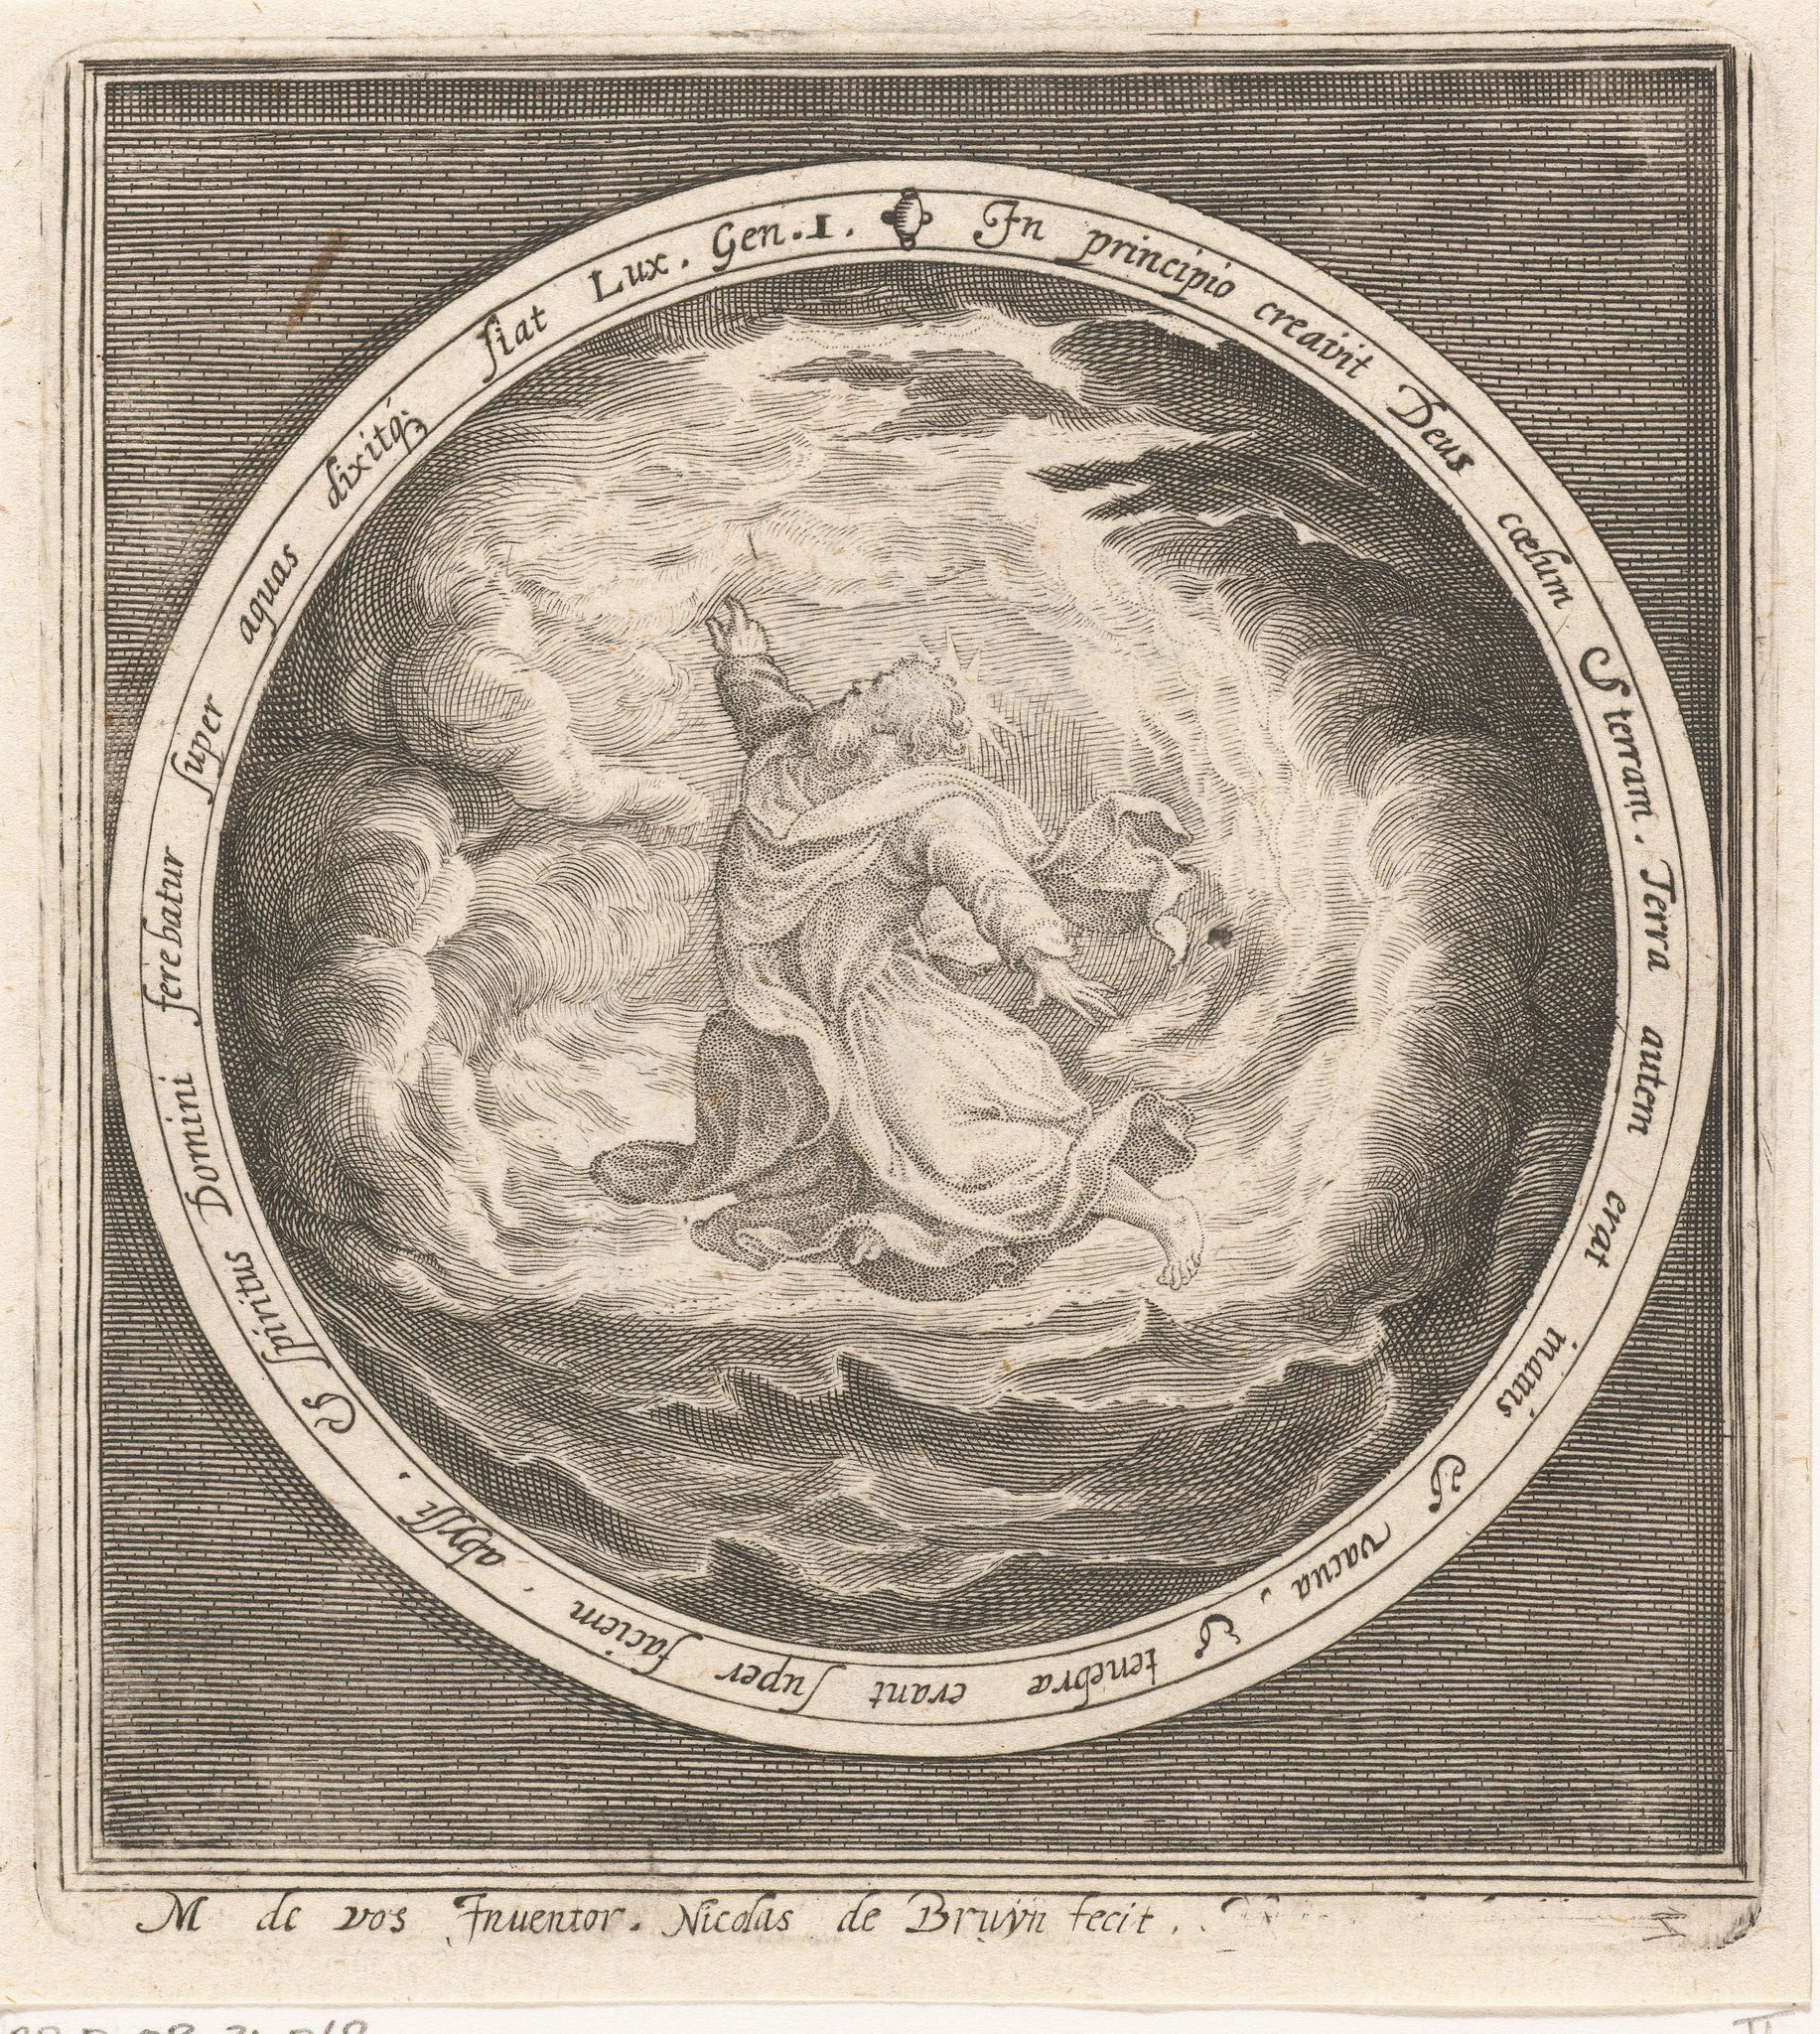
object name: print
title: Eerste dag van schepping: God schept hemel en aarde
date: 1581-1656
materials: paper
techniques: engraving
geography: netherlands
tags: division of light and darkness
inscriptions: collector's mark: Lugt 2228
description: Eerste dag van schepping: God schept hemel en aarde. In medaillon met als opschrift een bijbeltekst in Latijn uit Genesis 1, binnen rechthoekige omlijsting.